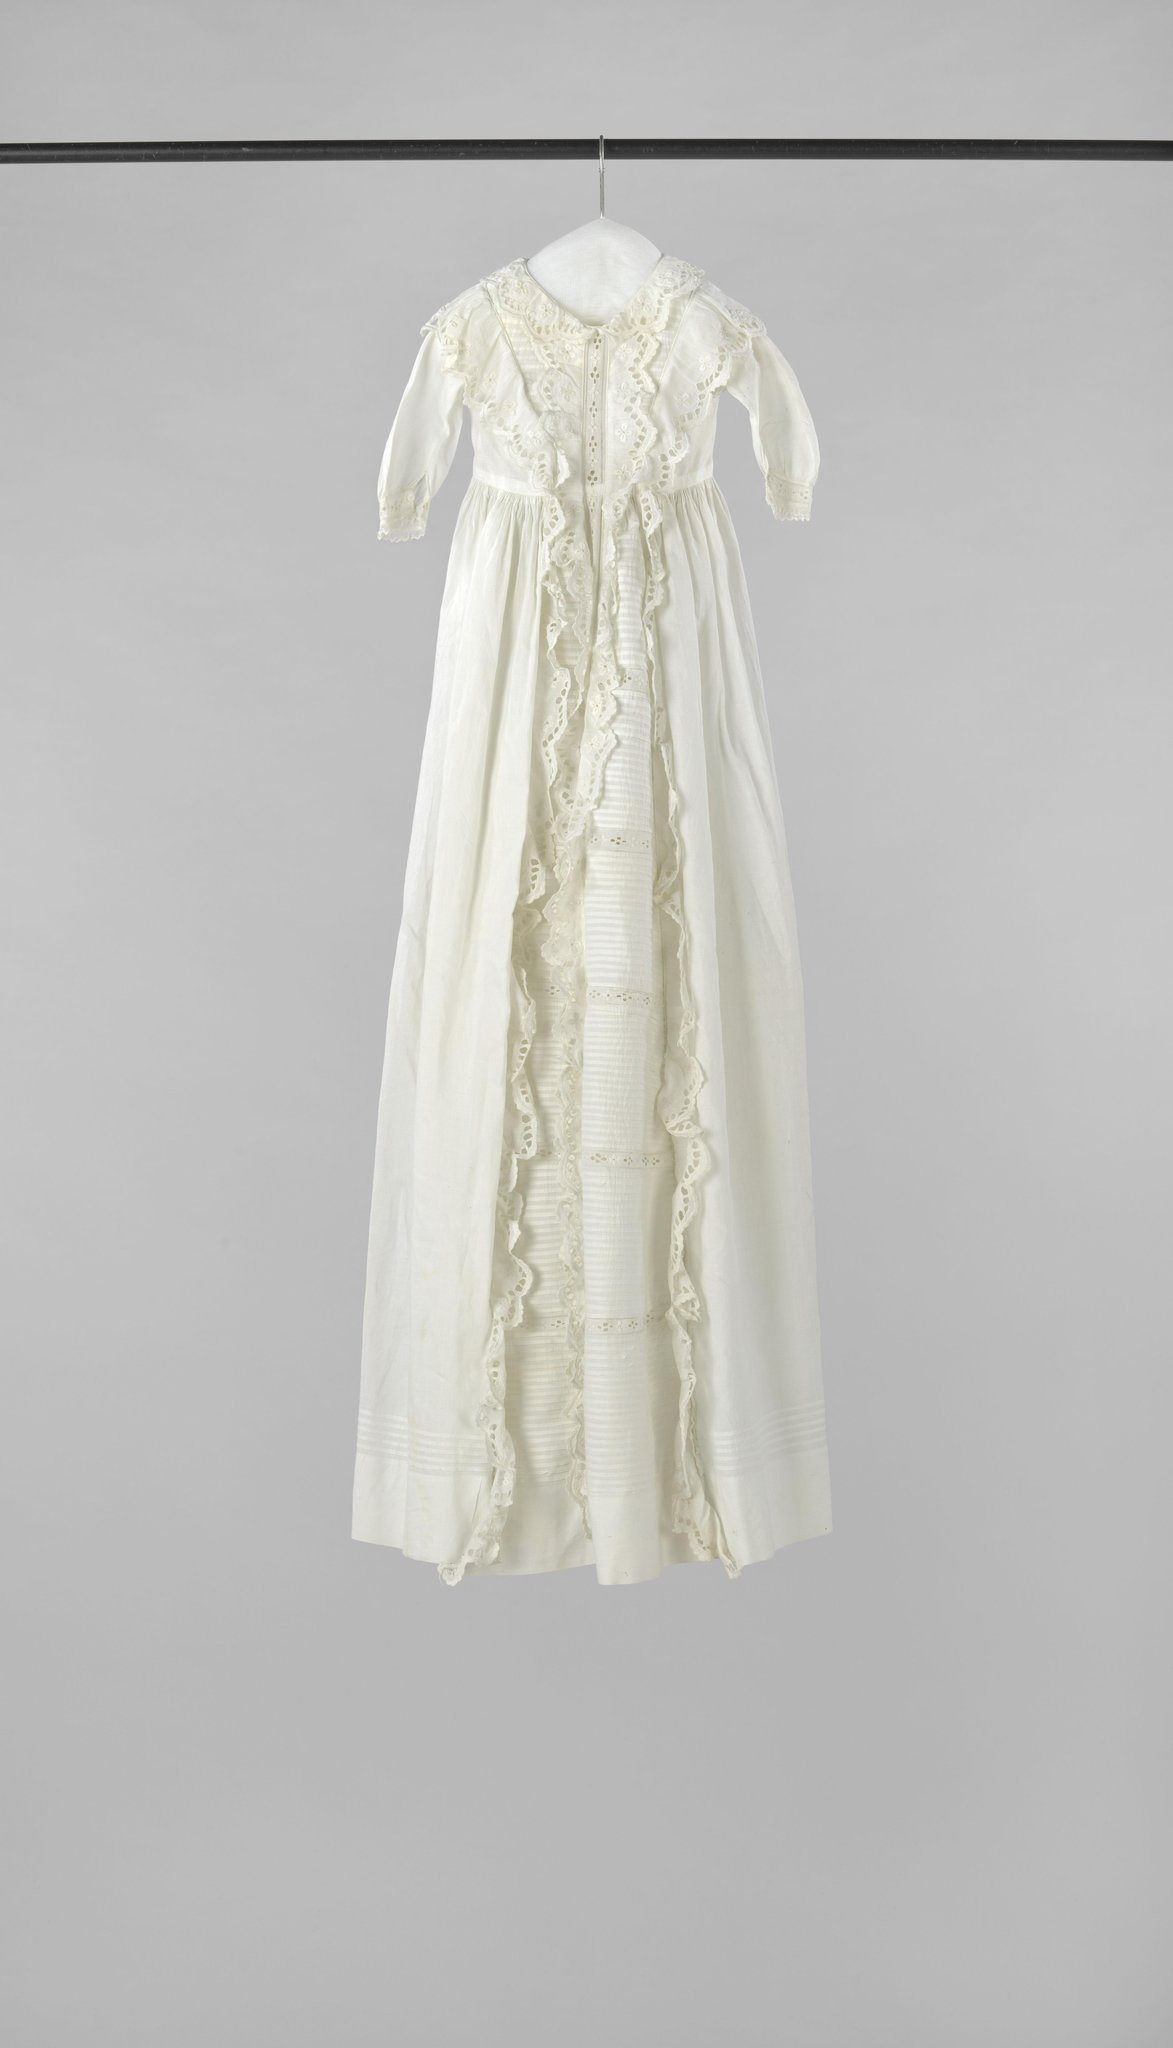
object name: doopjurk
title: Witte doopjurk met witwerk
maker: Anonymous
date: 1910-1940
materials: textile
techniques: lace, embroidery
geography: europe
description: De doopjurk heeft een rechte zoom met daarboven vijf oprijgjes. Aan de uiteinden van de mouwen een geschulpte strook Valenciennes-kant. Aan de achterzijde bij de hals sluit de jurk met drie ronde witte knopen.